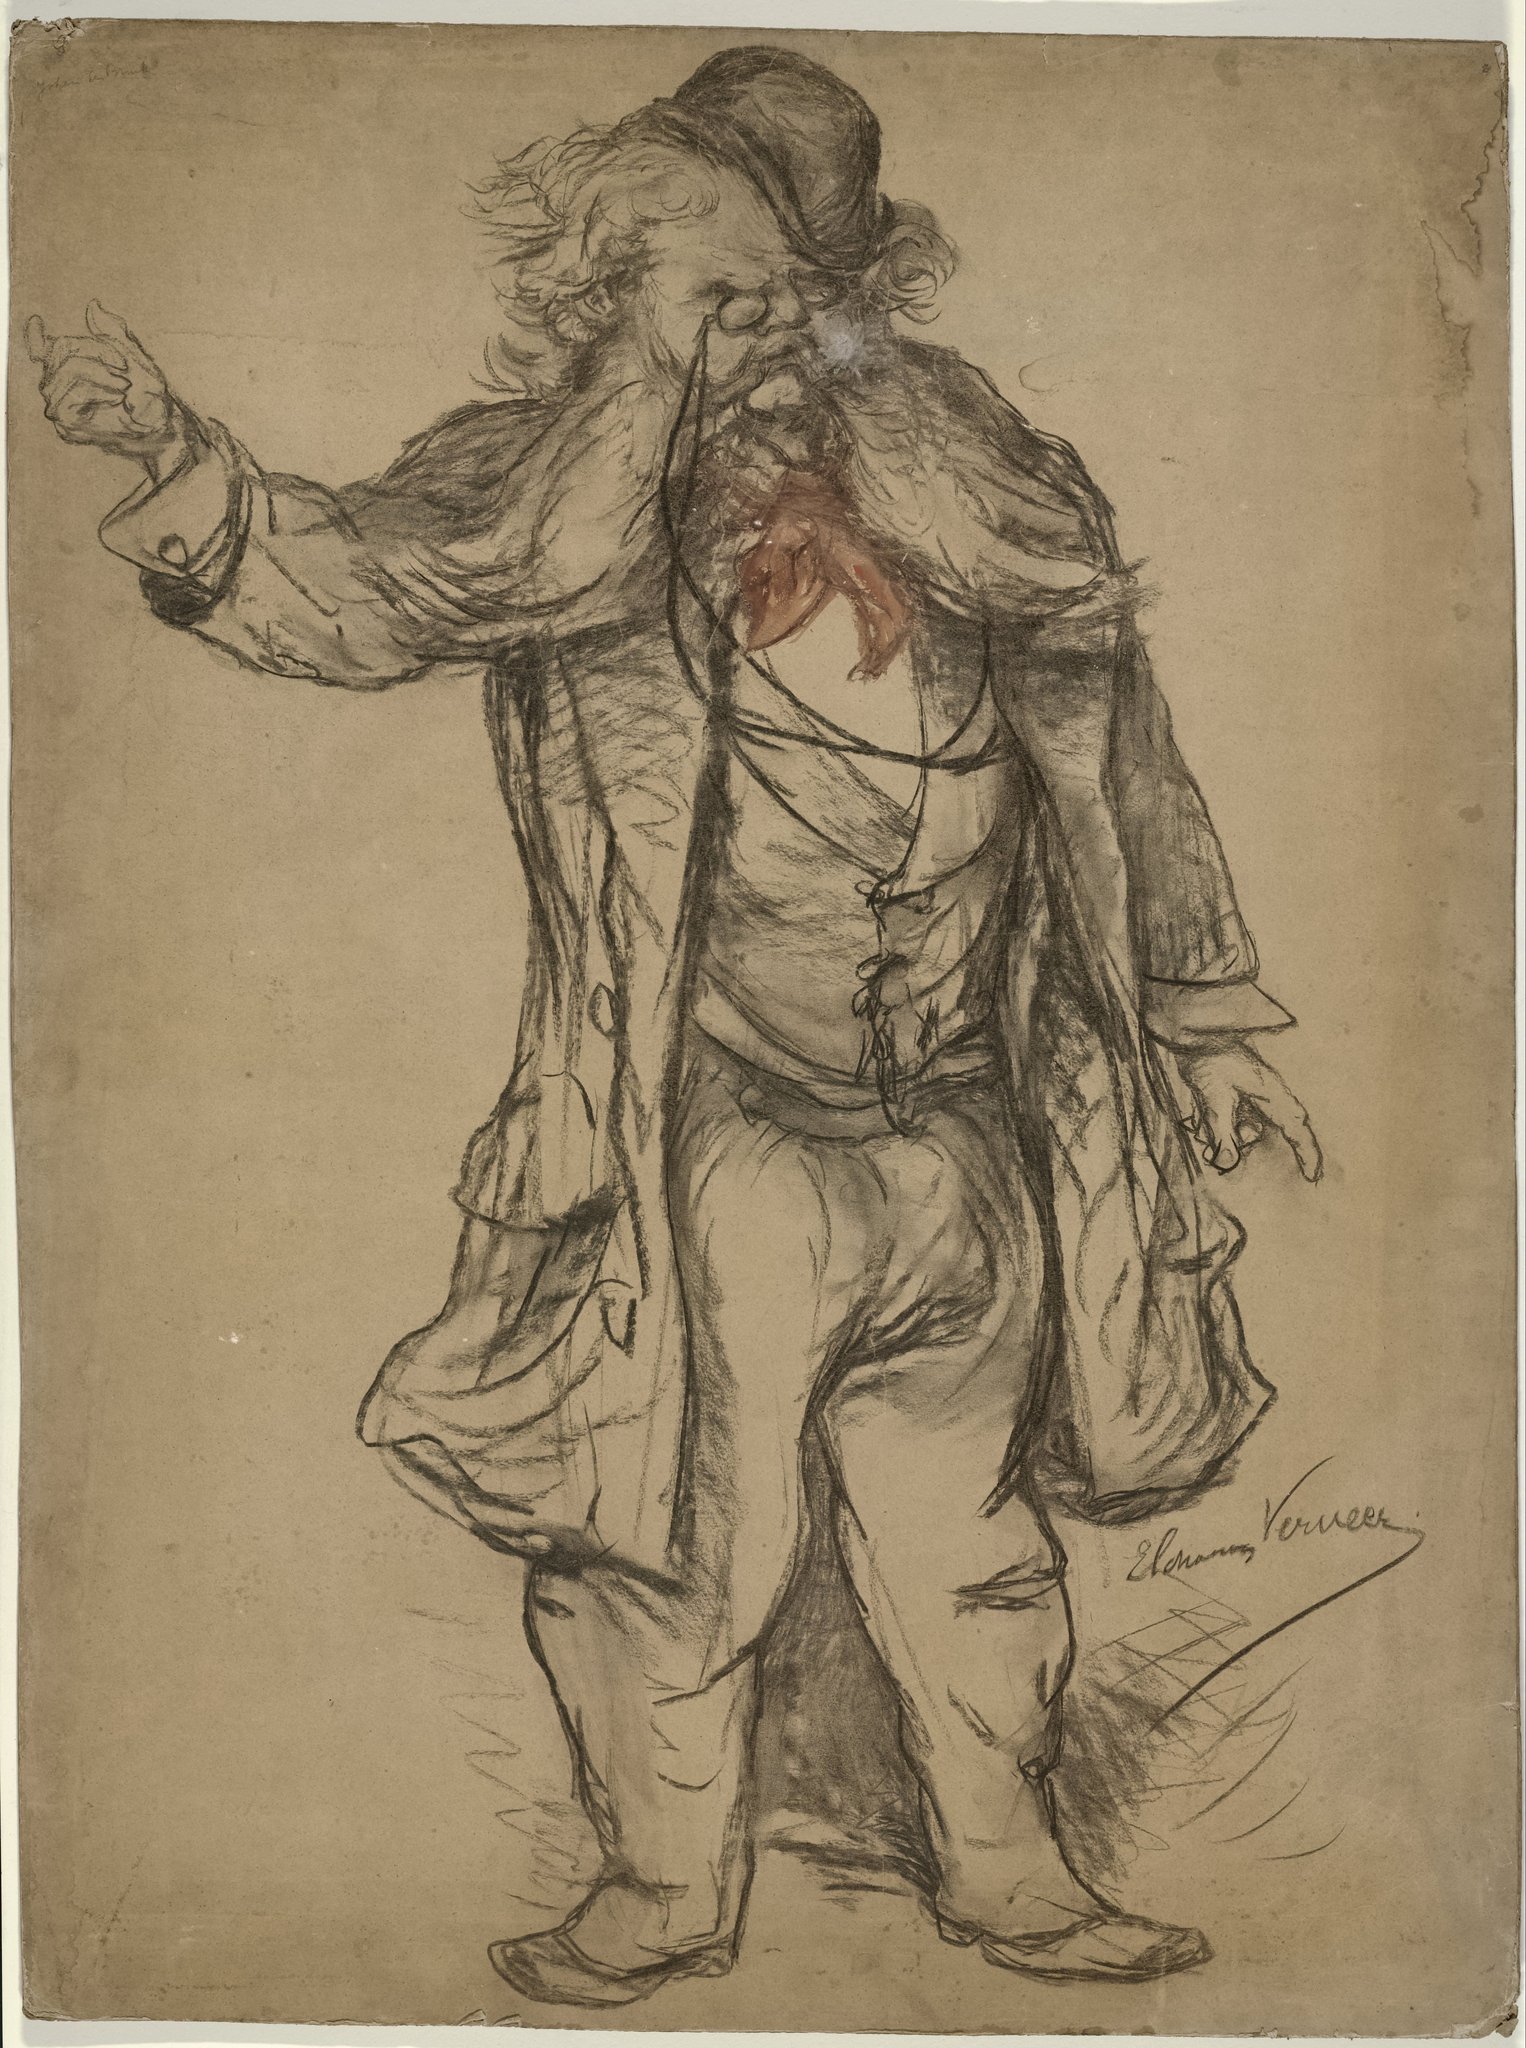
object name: drawing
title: Karikatuurportret van Prof. Jan ten Brink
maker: elchanon verveer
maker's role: draughtsman, print maker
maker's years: 1826-1900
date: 1850-1899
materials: charcoal, paper, watercolor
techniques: brush, stumping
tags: leiden, jan ten brink (1834-1901)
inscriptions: signature: ‘Elchanon Verveer’, inscription: ‘Johan ten Brink’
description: Karikatuurportret van de letterkundige Prof. Jan ten Brink (1834-1901).